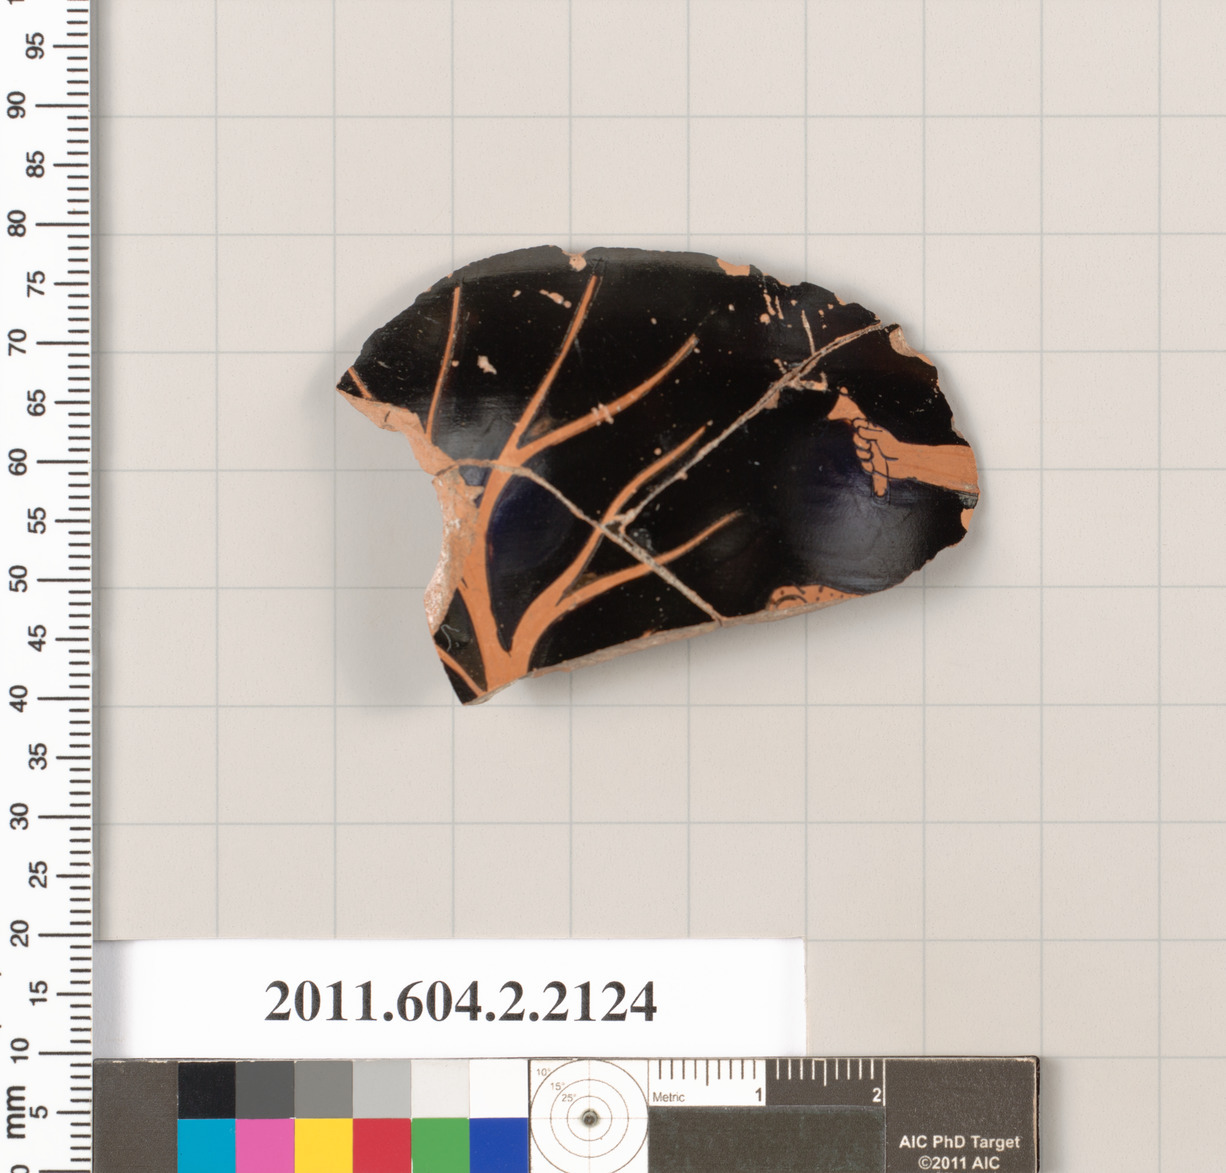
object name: chou fragment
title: Terracotta fragment of a chous (jug)?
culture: greek, attic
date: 480-470 BCE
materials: terracotta